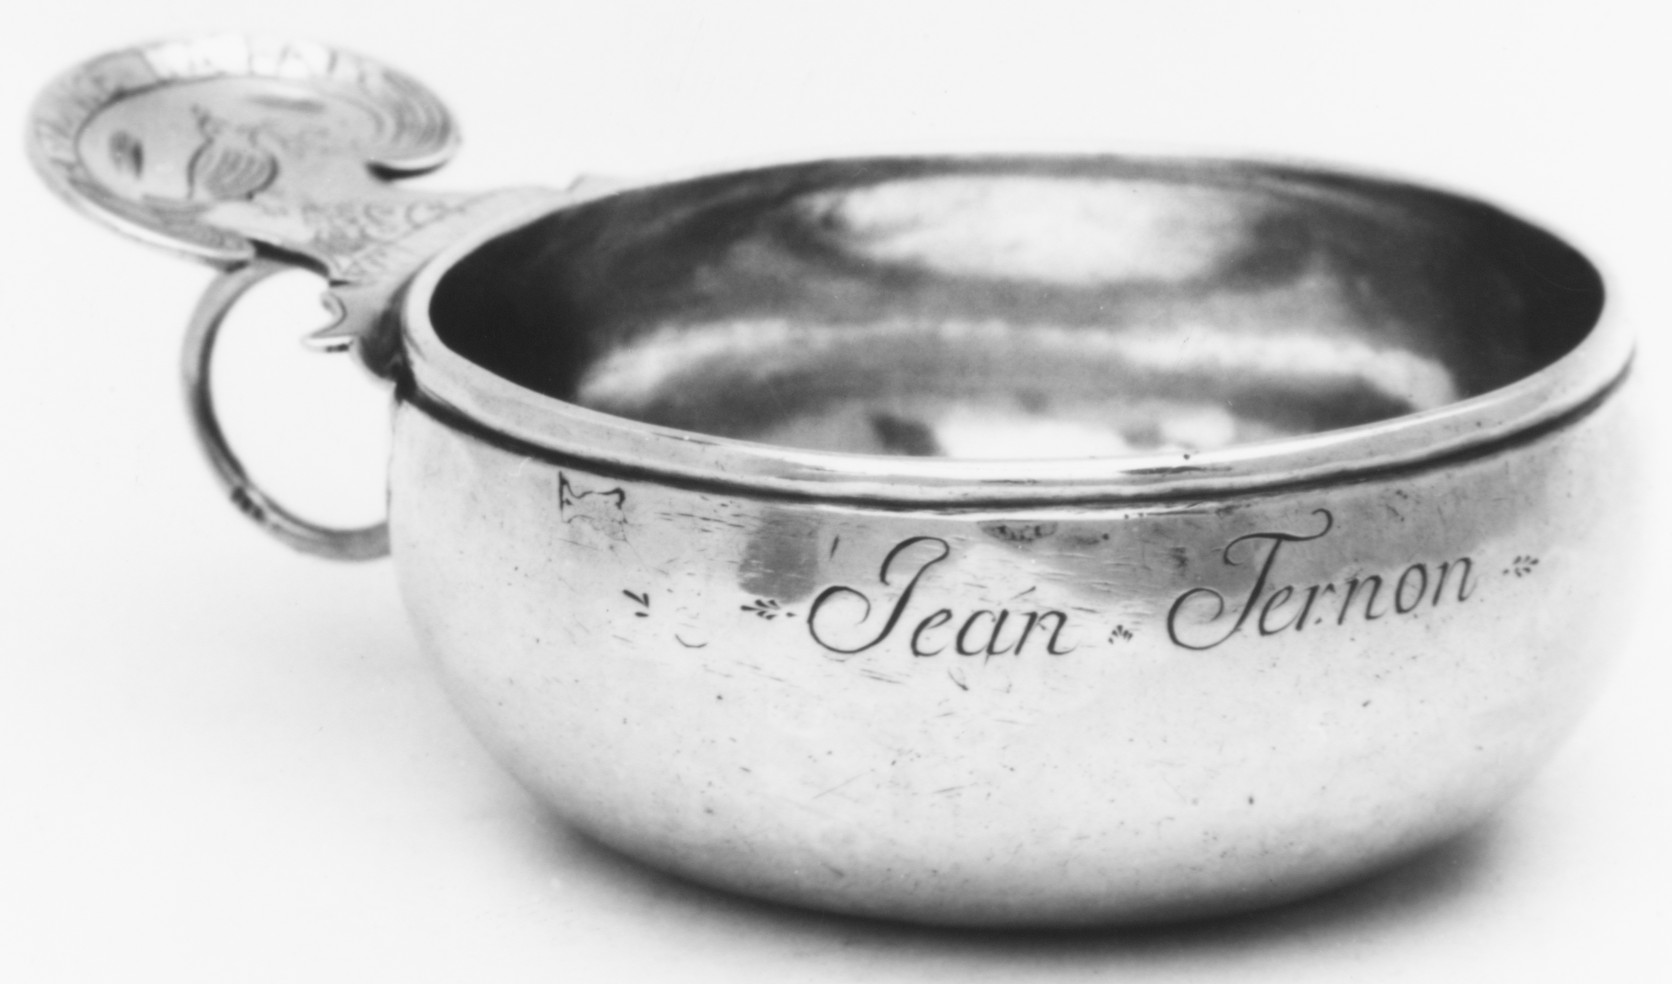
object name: wine taster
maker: charles lagenet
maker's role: maker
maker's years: 1732-1752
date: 1738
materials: silver